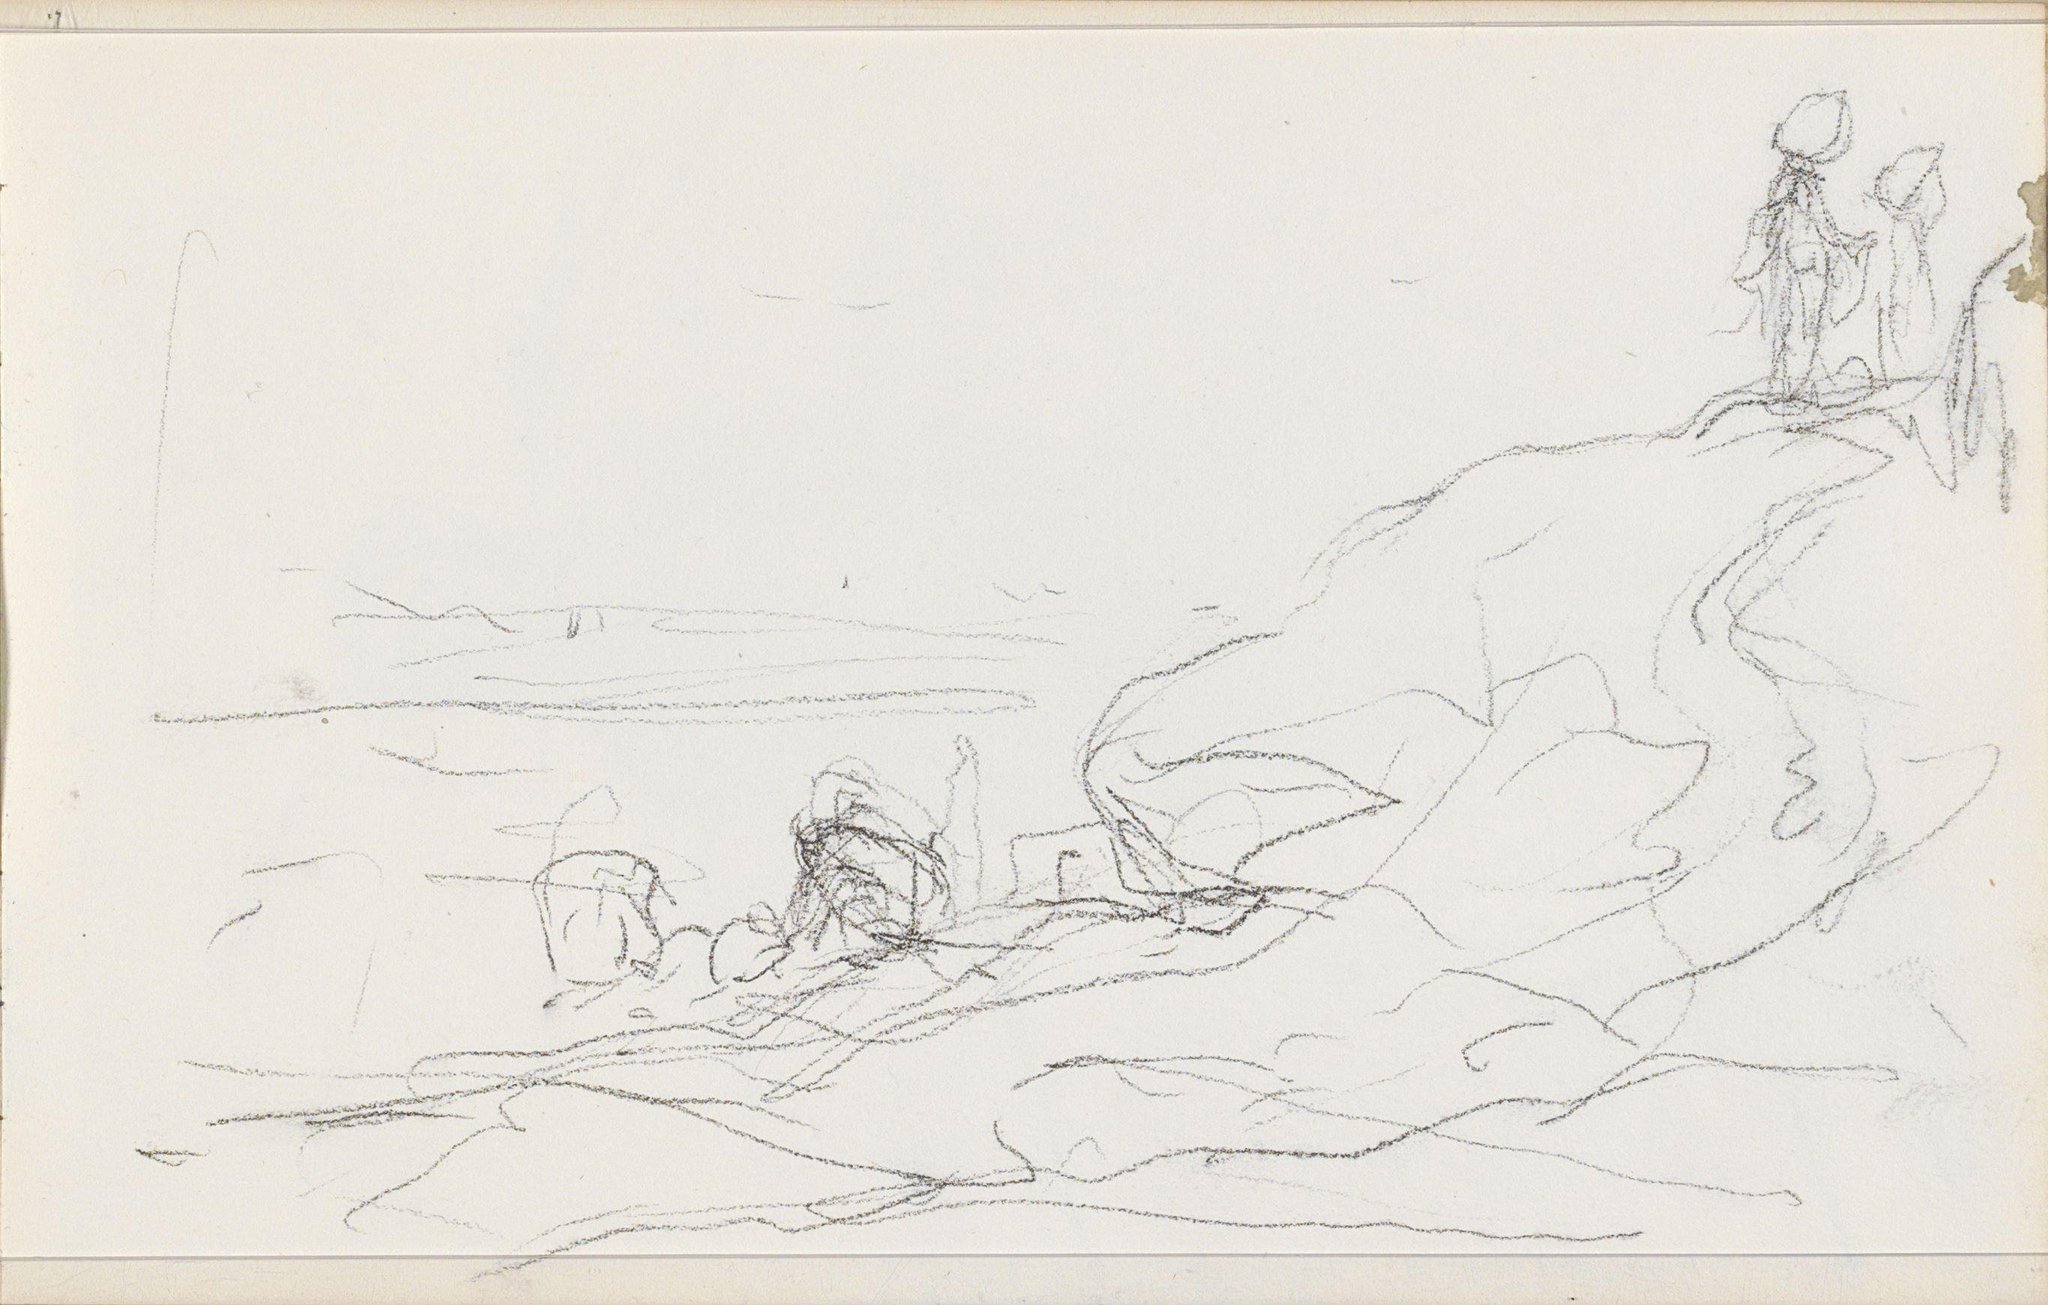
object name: sketchbook leaf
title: Figuren in een rotsachtig woestijnlandschap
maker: marius bauer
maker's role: draughtsman, print maker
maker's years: 1867-1932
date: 1919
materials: chalk, paper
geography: egypt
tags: desert, rocks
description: Pagina 17 uit een schetsboek met 18 bladen.